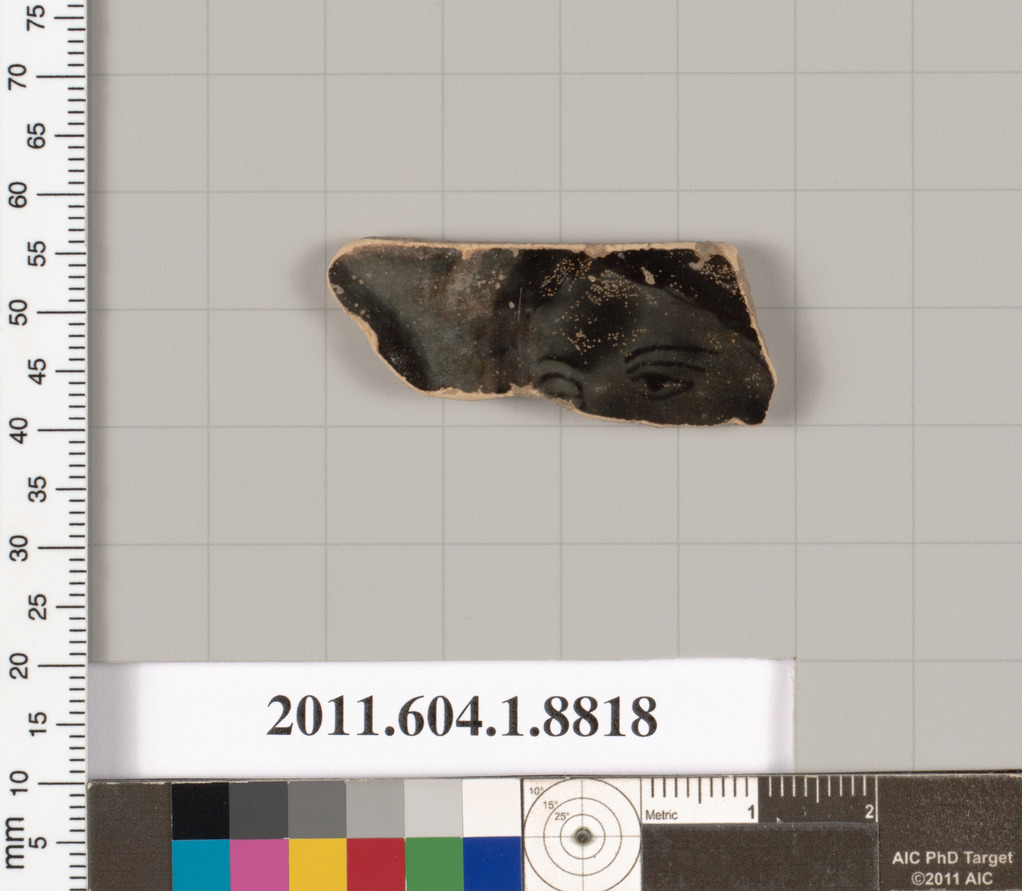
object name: kylix fragment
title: Terracotta fragment of a kylix (drinking cup)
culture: greek, attic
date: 467-435 BCE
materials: terracotta